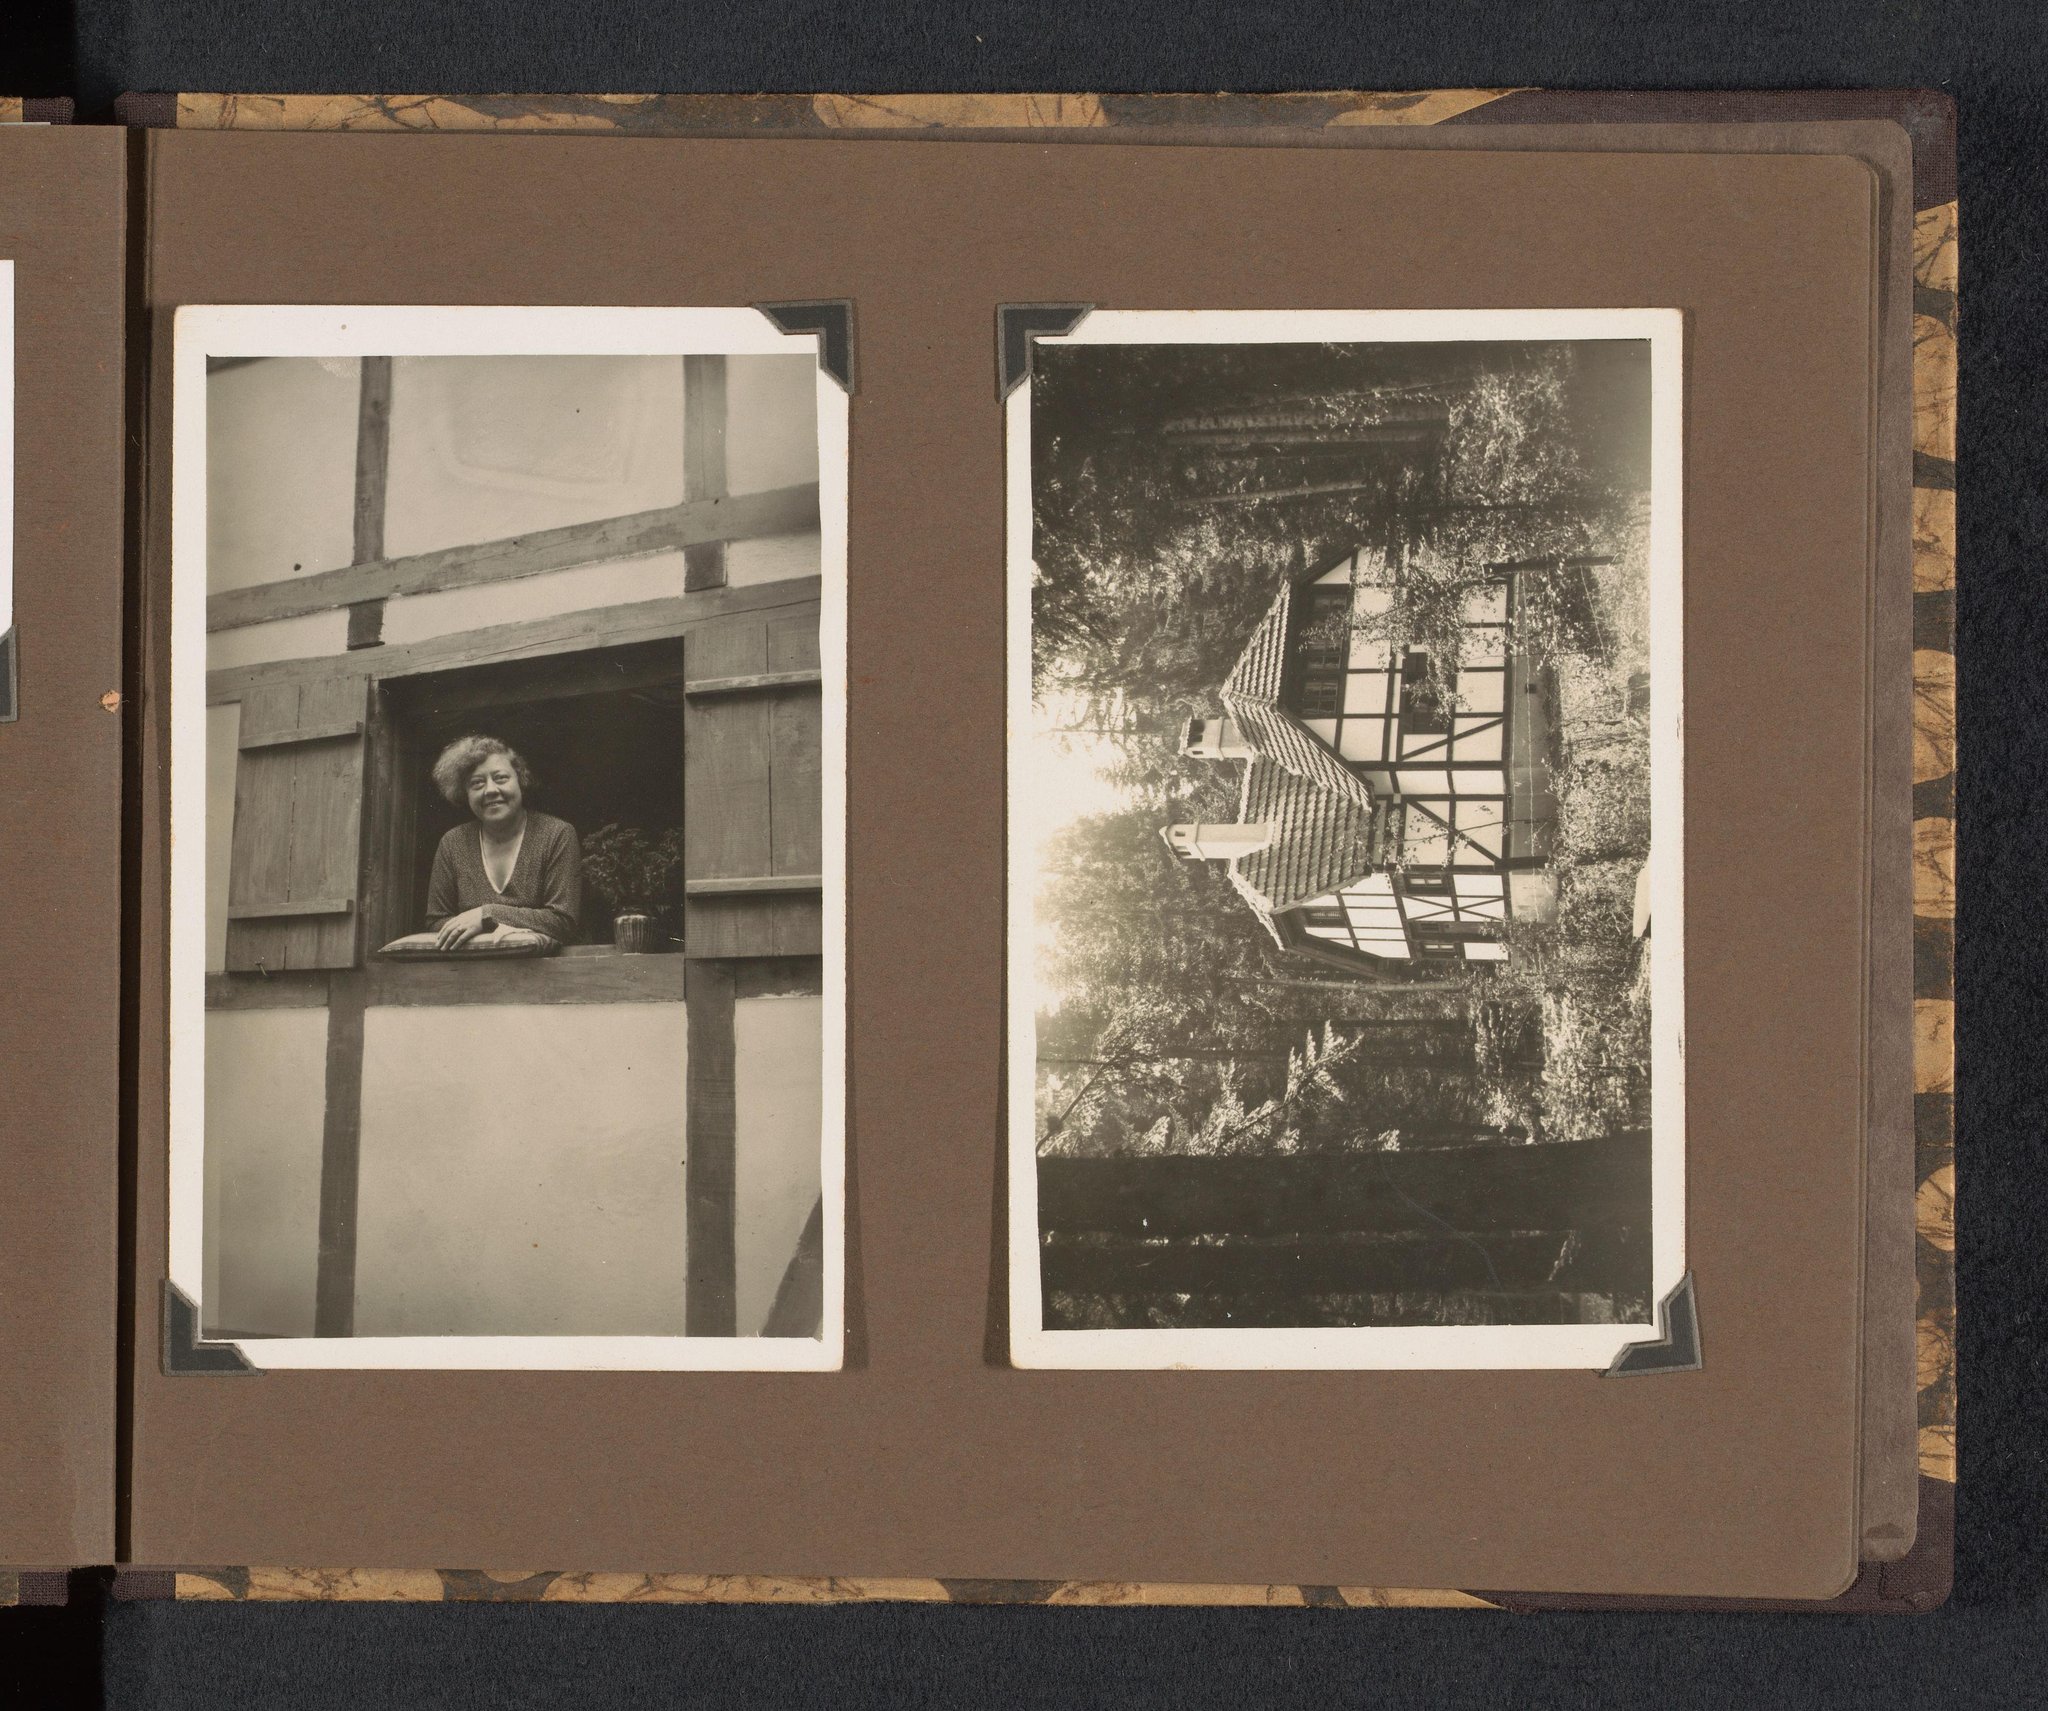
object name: album leaf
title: Onbekende vrouw en huis, mogelijk tijdens rondreis van Eugen Wachenheimer en Else Wachenheimer-Moos door Bulgarije, 1926-1927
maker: else wachenheimer-moos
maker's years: 1895-1944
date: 1926-1927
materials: paper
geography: bulgaria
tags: bulgarije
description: Albumblad bevat twee foto's van onbekende personen. Afkomstig uit album half formaat, kartonomslag met koordbinding en lichte veelvormige vormen op voorzijde.